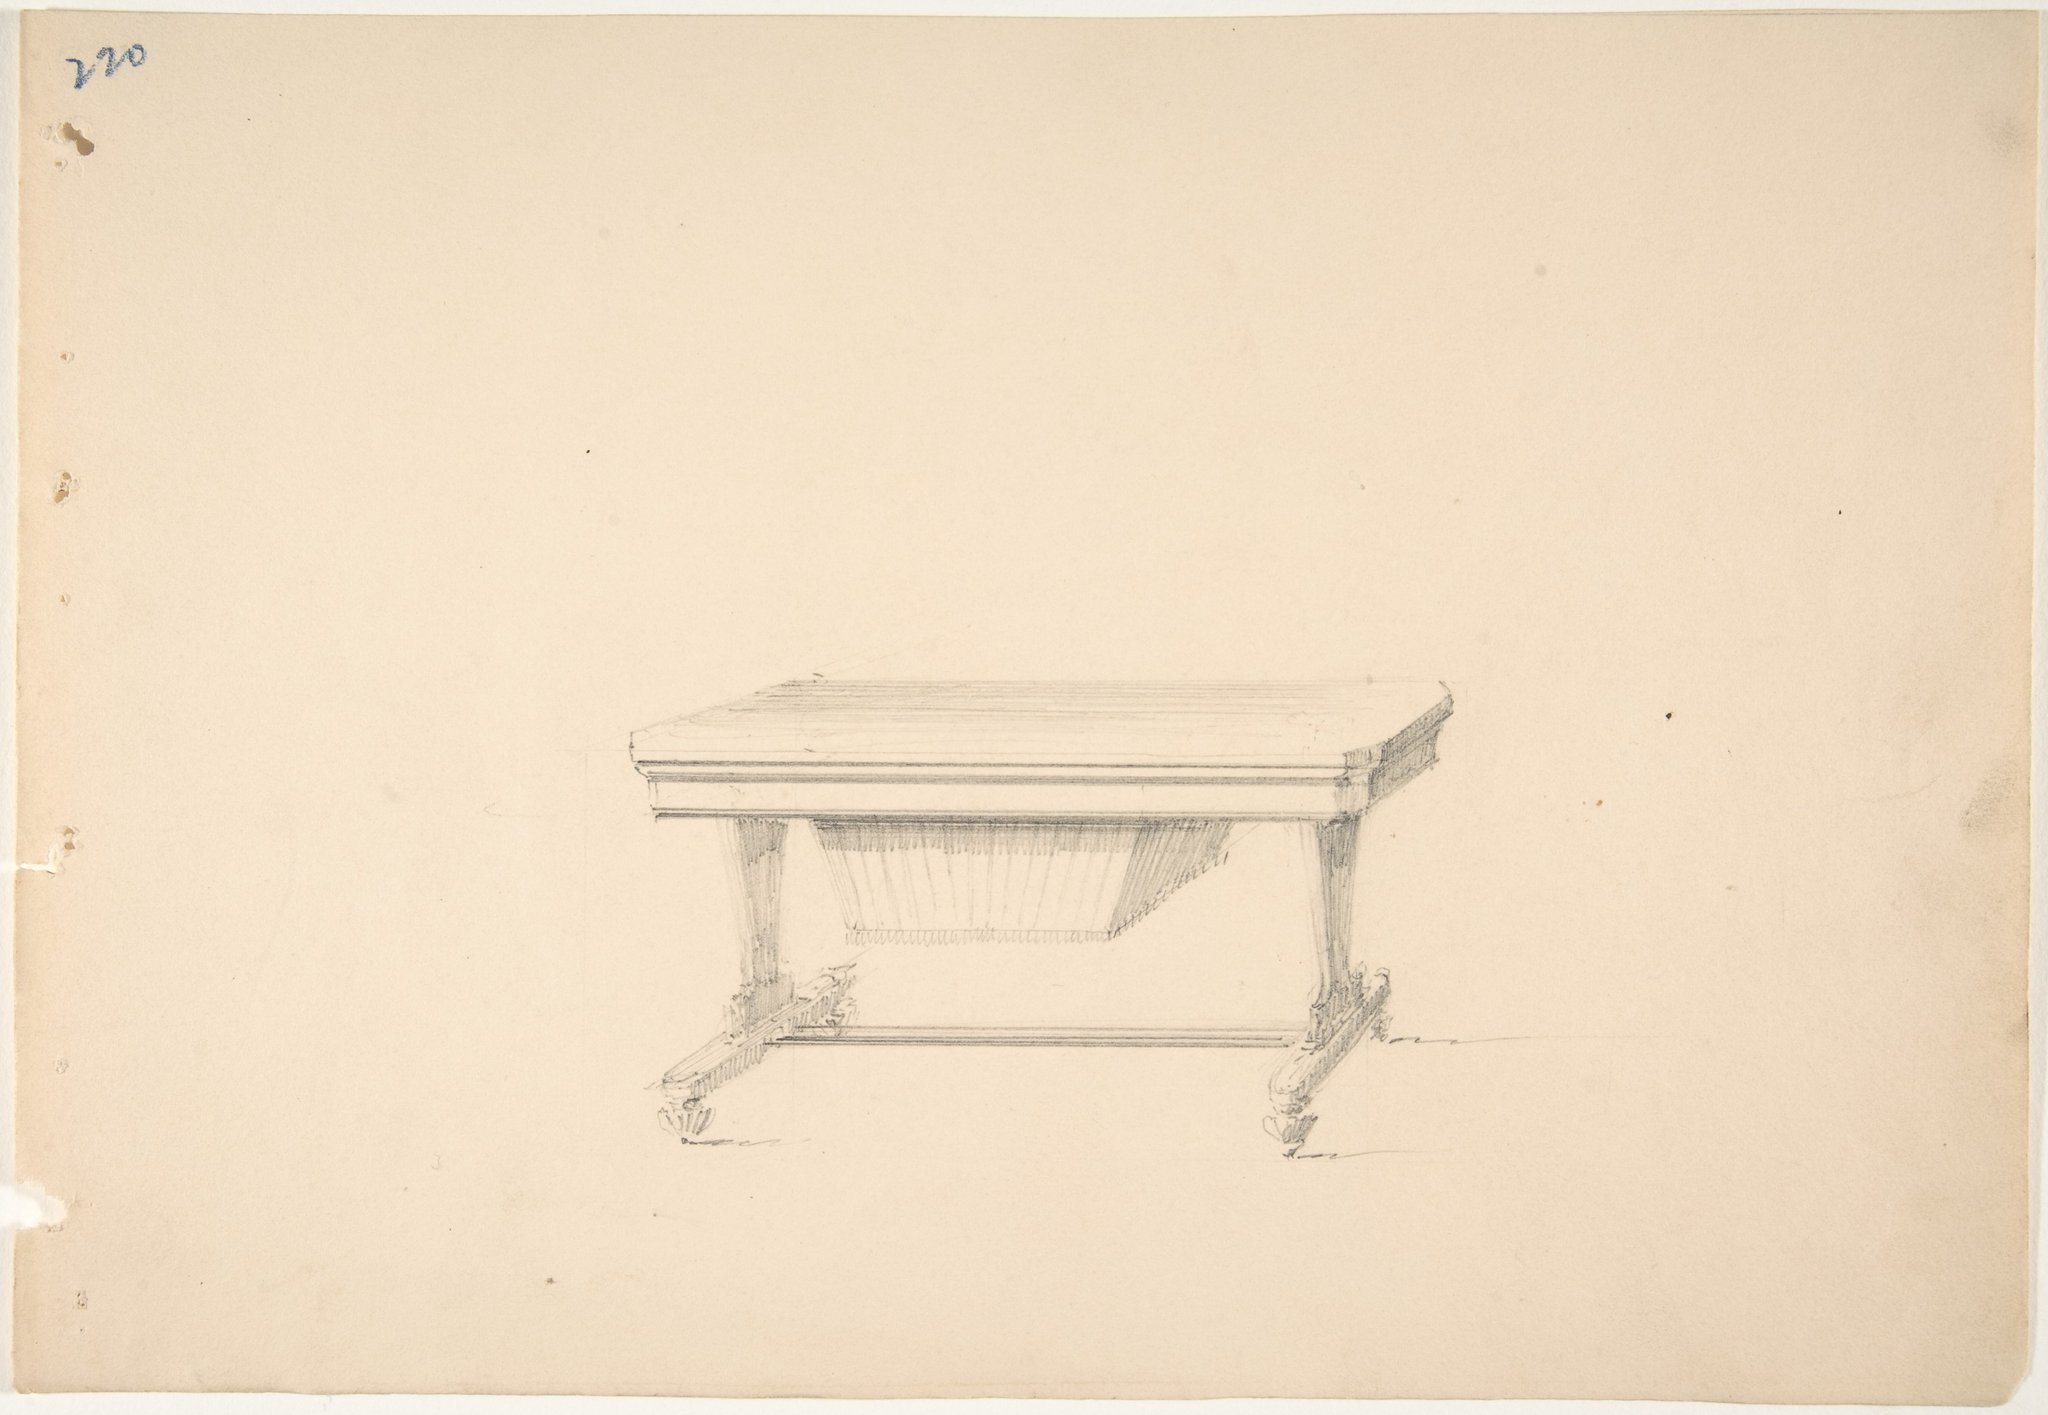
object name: drawing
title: Design for a Worktable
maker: anonymous, british, 19th century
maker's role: artist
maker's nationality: british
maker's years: 1800-1900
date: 1801-1833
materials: graphite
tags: tables